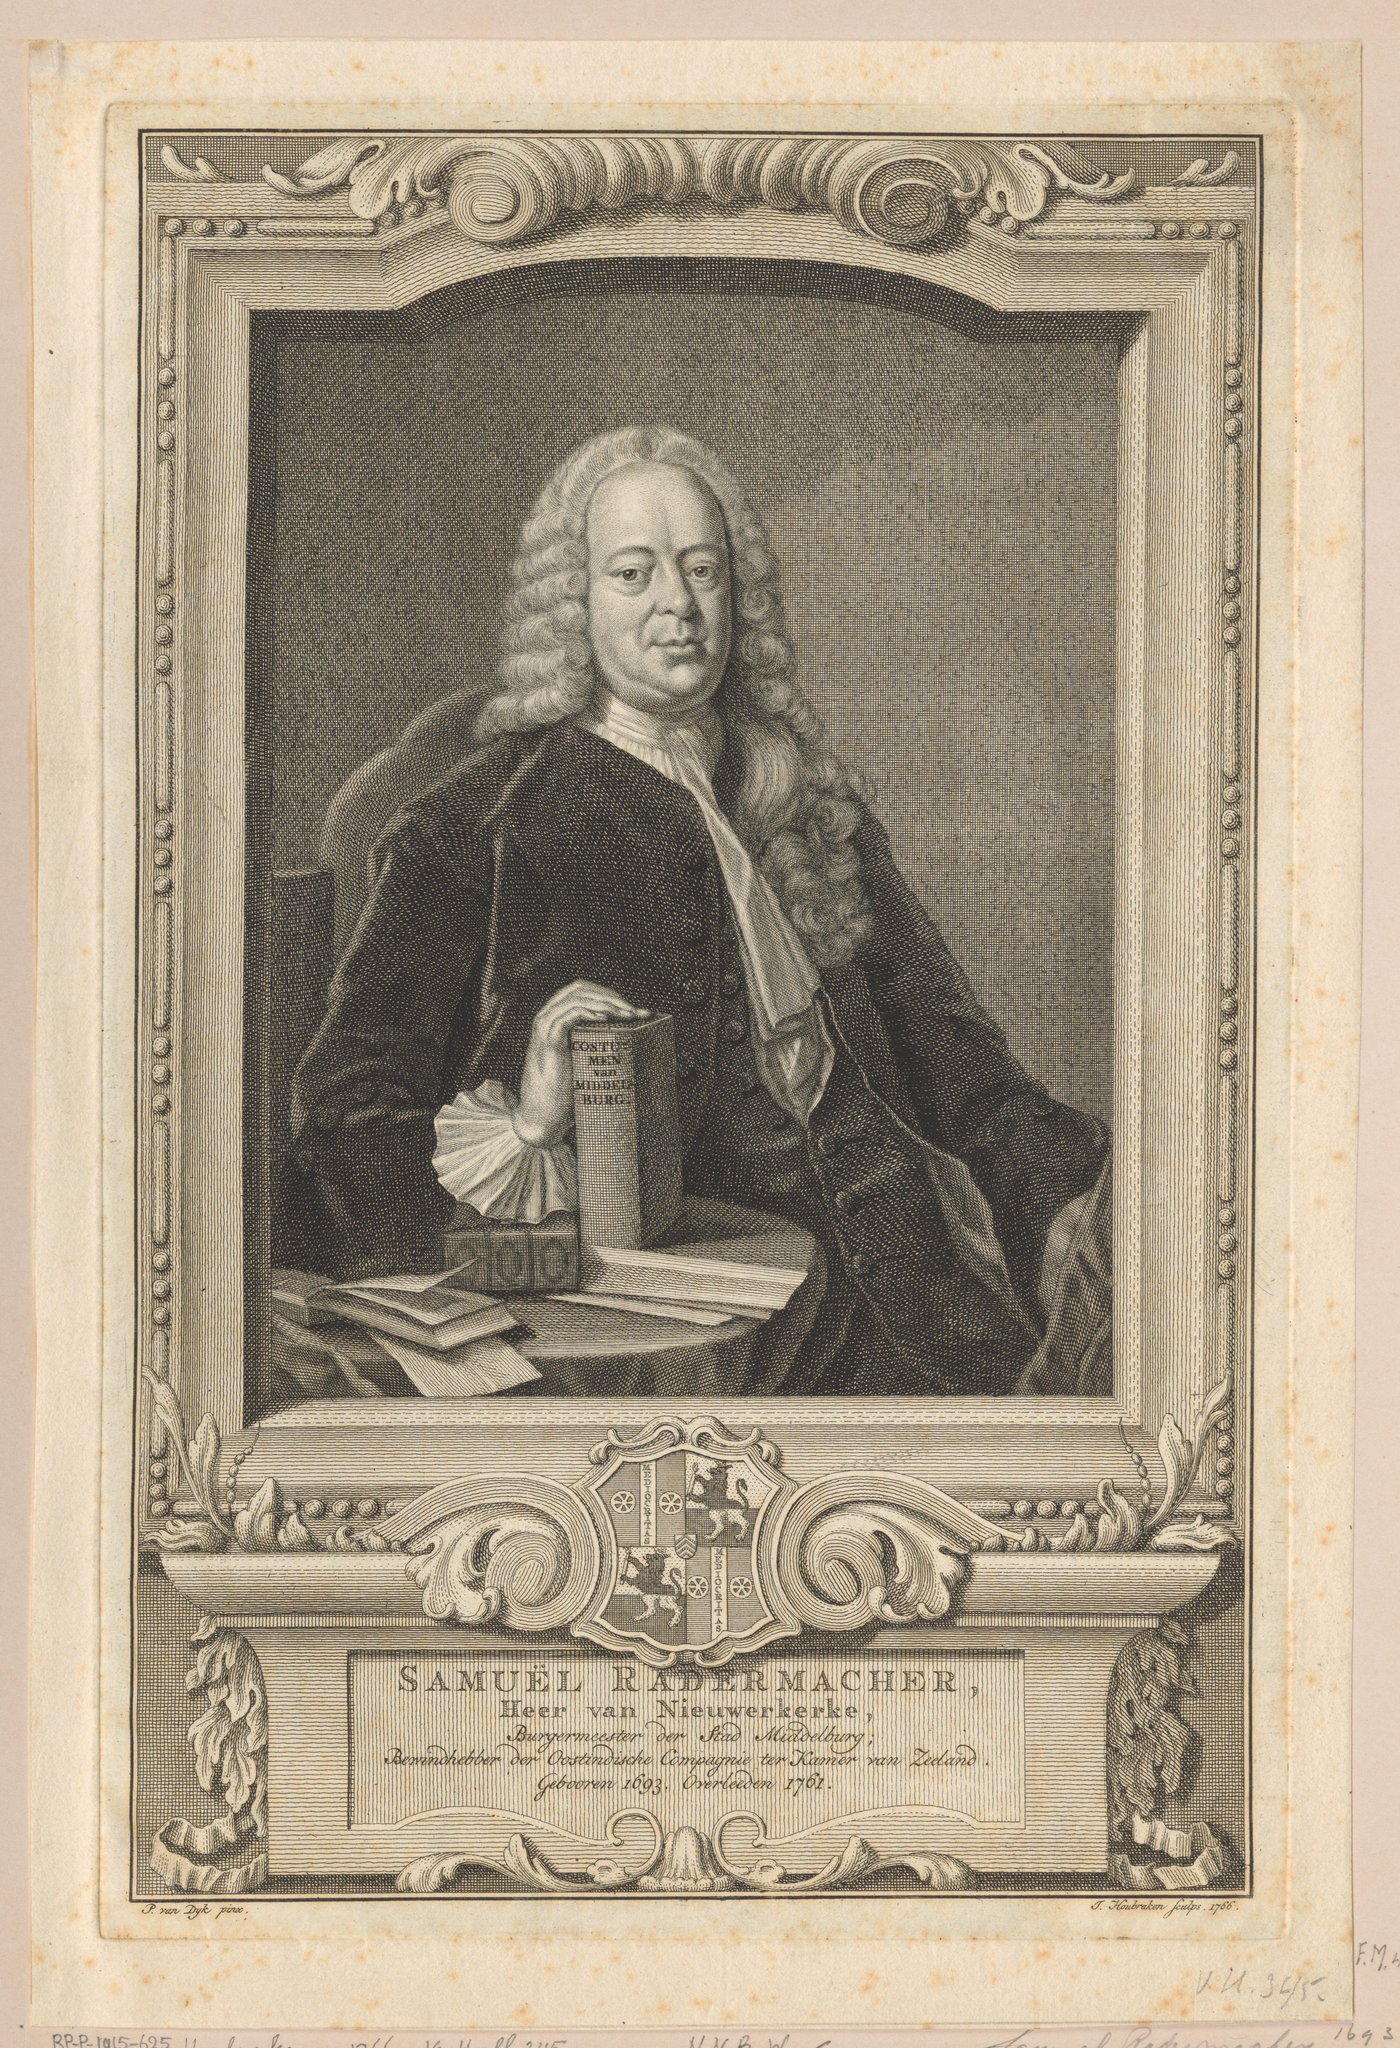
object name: print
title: Portret van Samuel Radermacher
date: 1766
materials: paper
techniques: engraving, etching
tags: mayor, historical persons, book, armorial bearing, heraldry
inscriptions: collector's mark: Lugt 2228